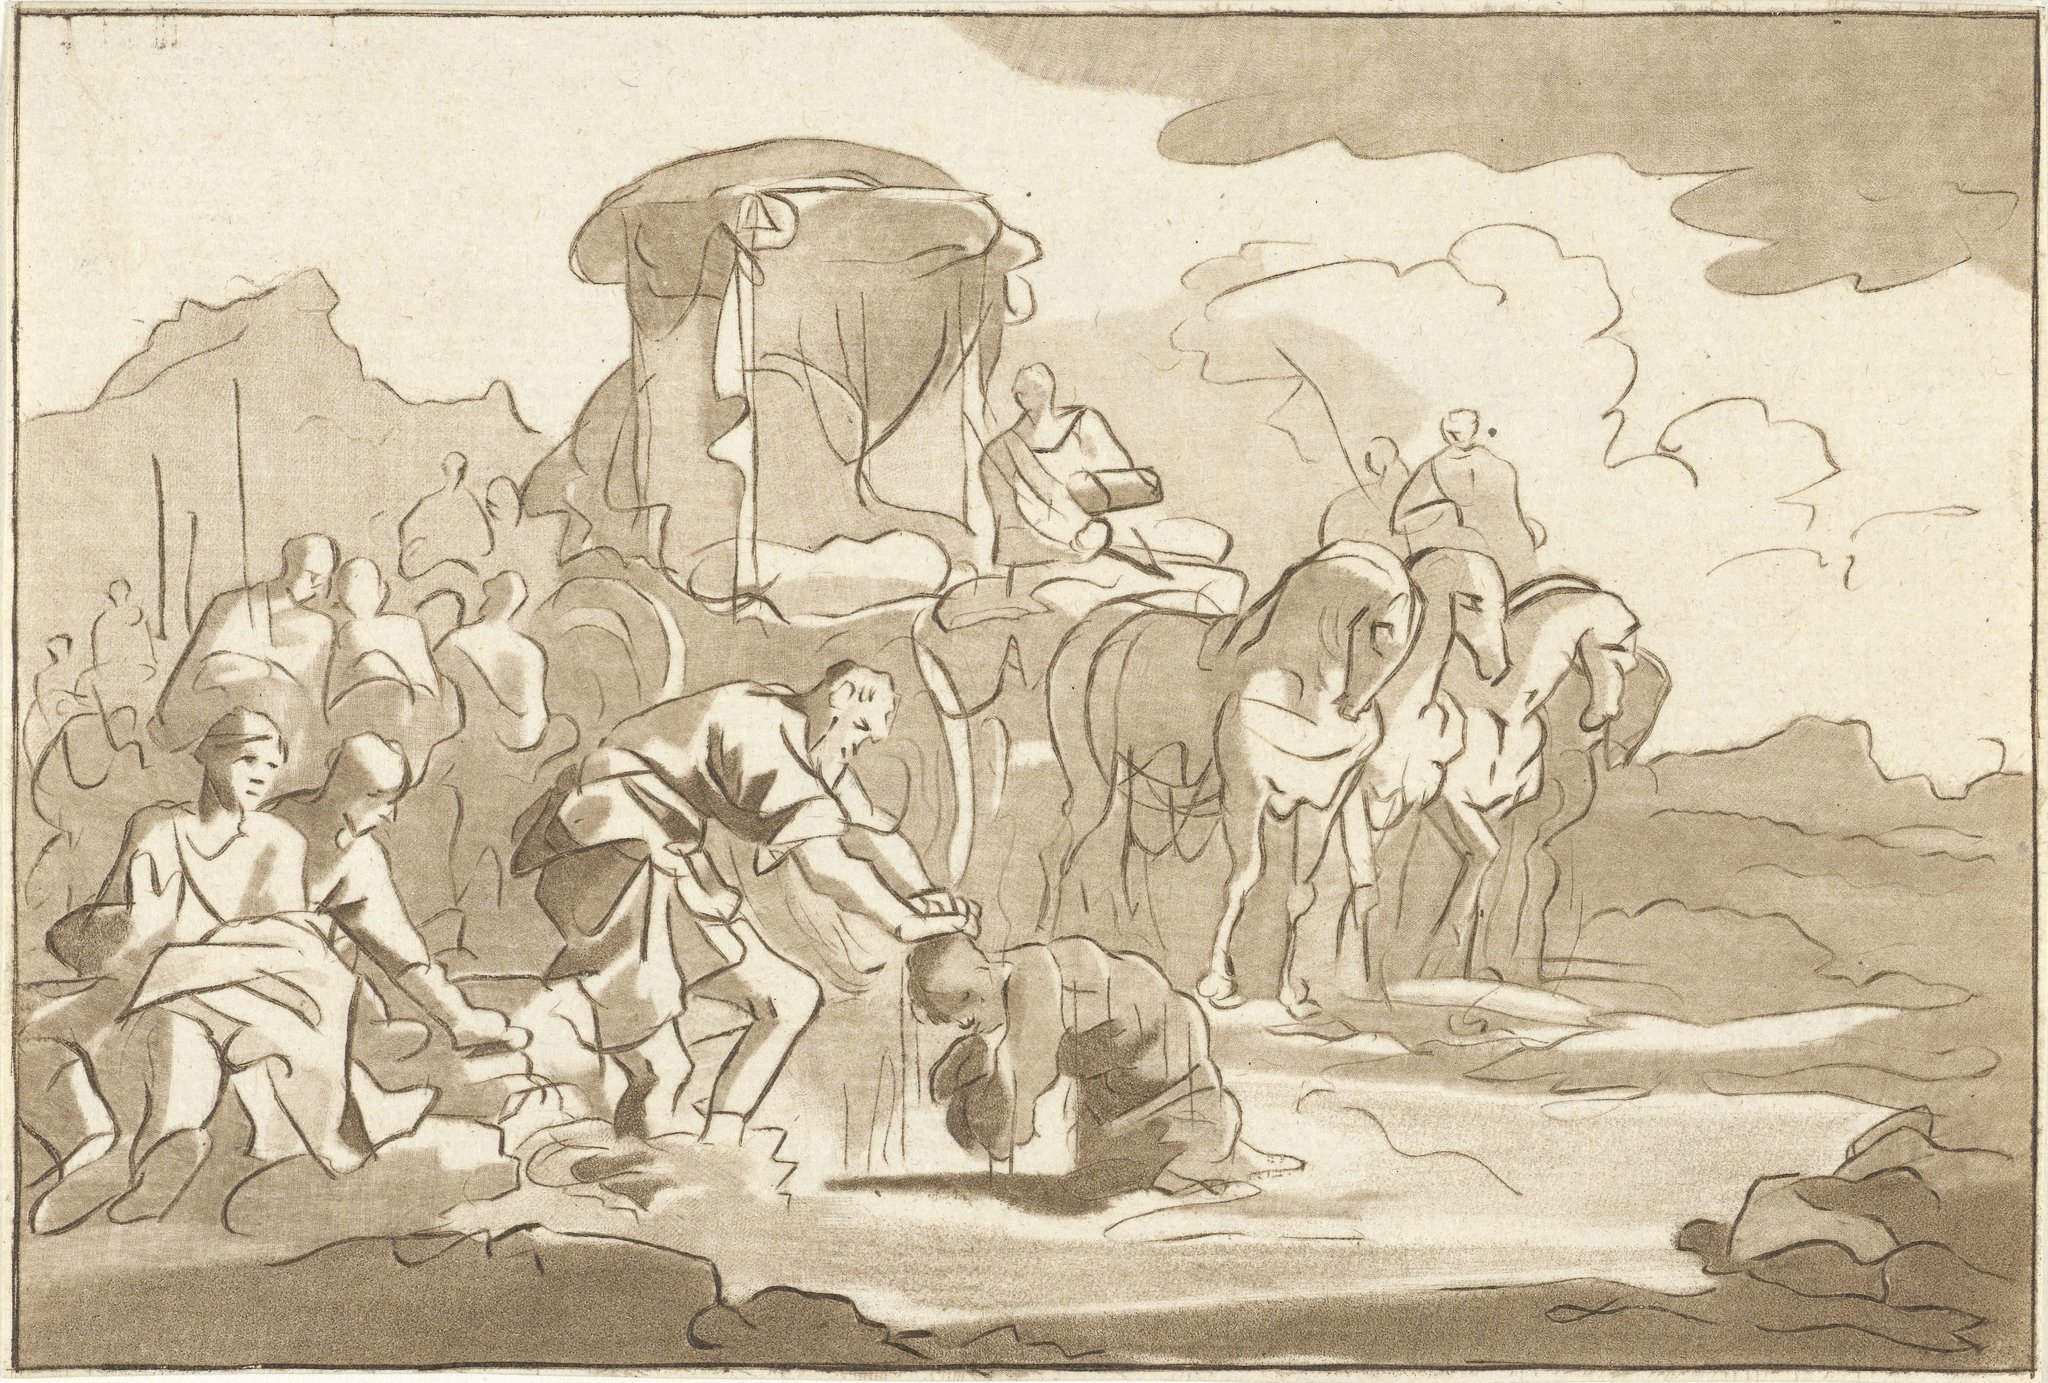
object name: print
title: Filippus doopt de kamerling of eunuch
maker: benjamin martini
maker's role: print maker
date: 1777-1780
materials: paper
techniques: aquatint, etching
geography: amsterdam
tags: philip baptizes the eunuch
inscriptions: collector's mark: Lugt 240